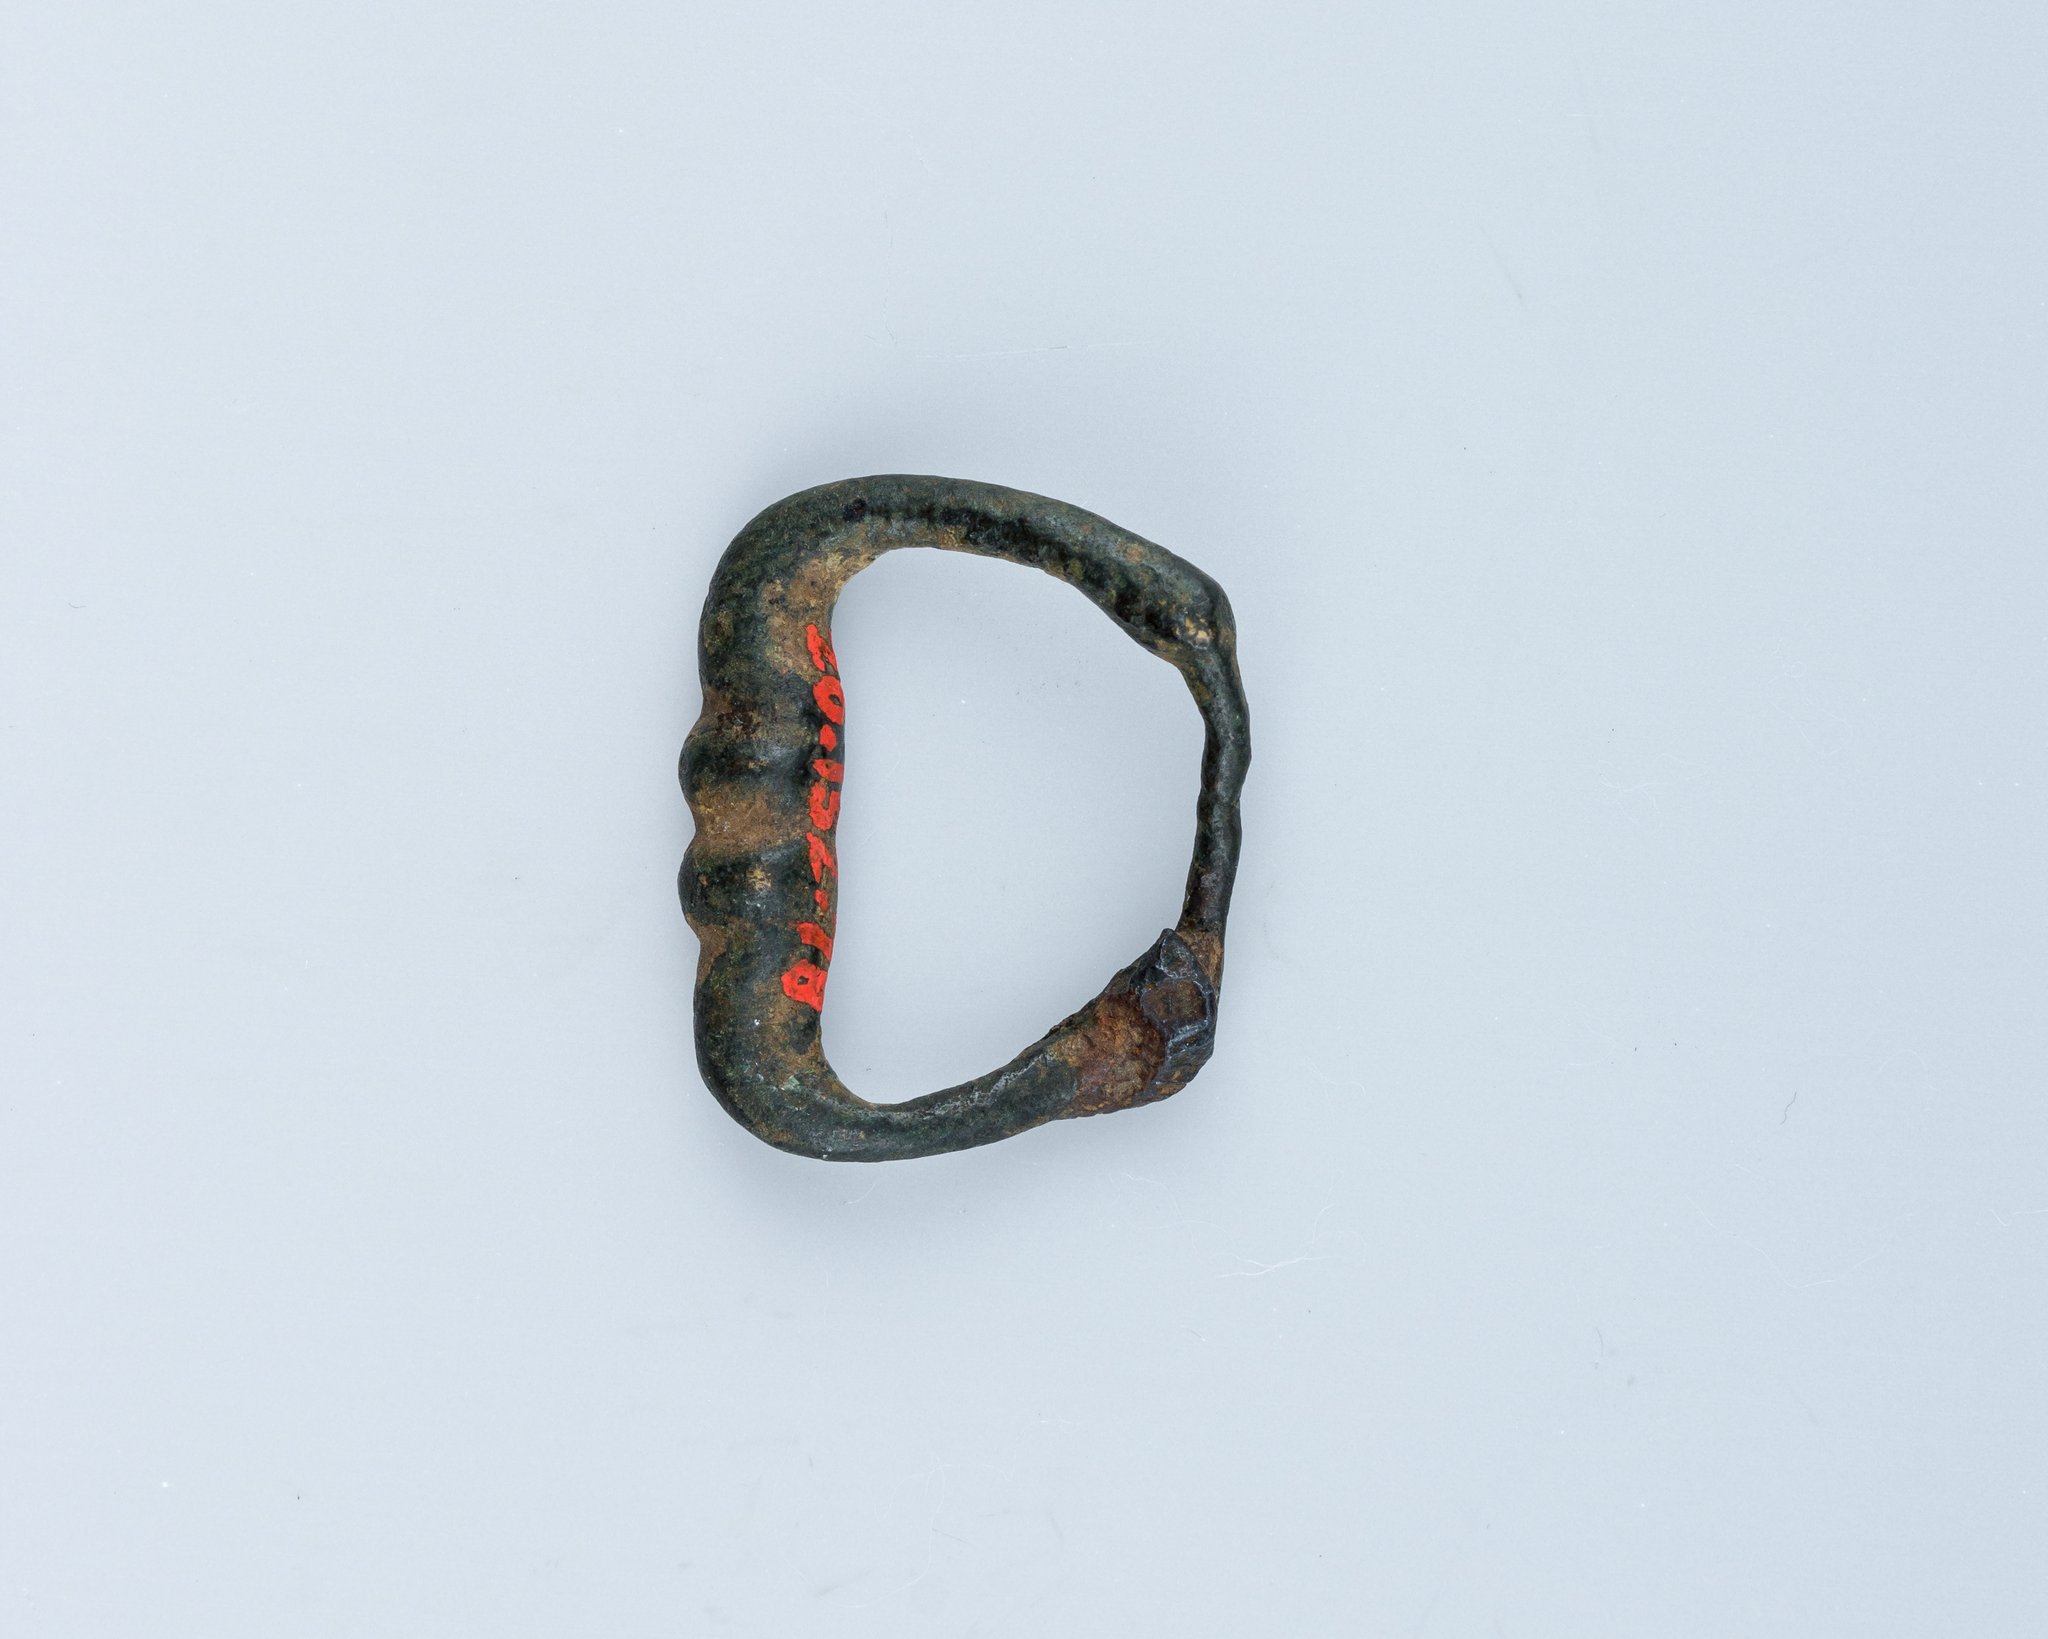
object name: buckle loop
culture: french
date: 1301-1400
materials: bronze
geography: france